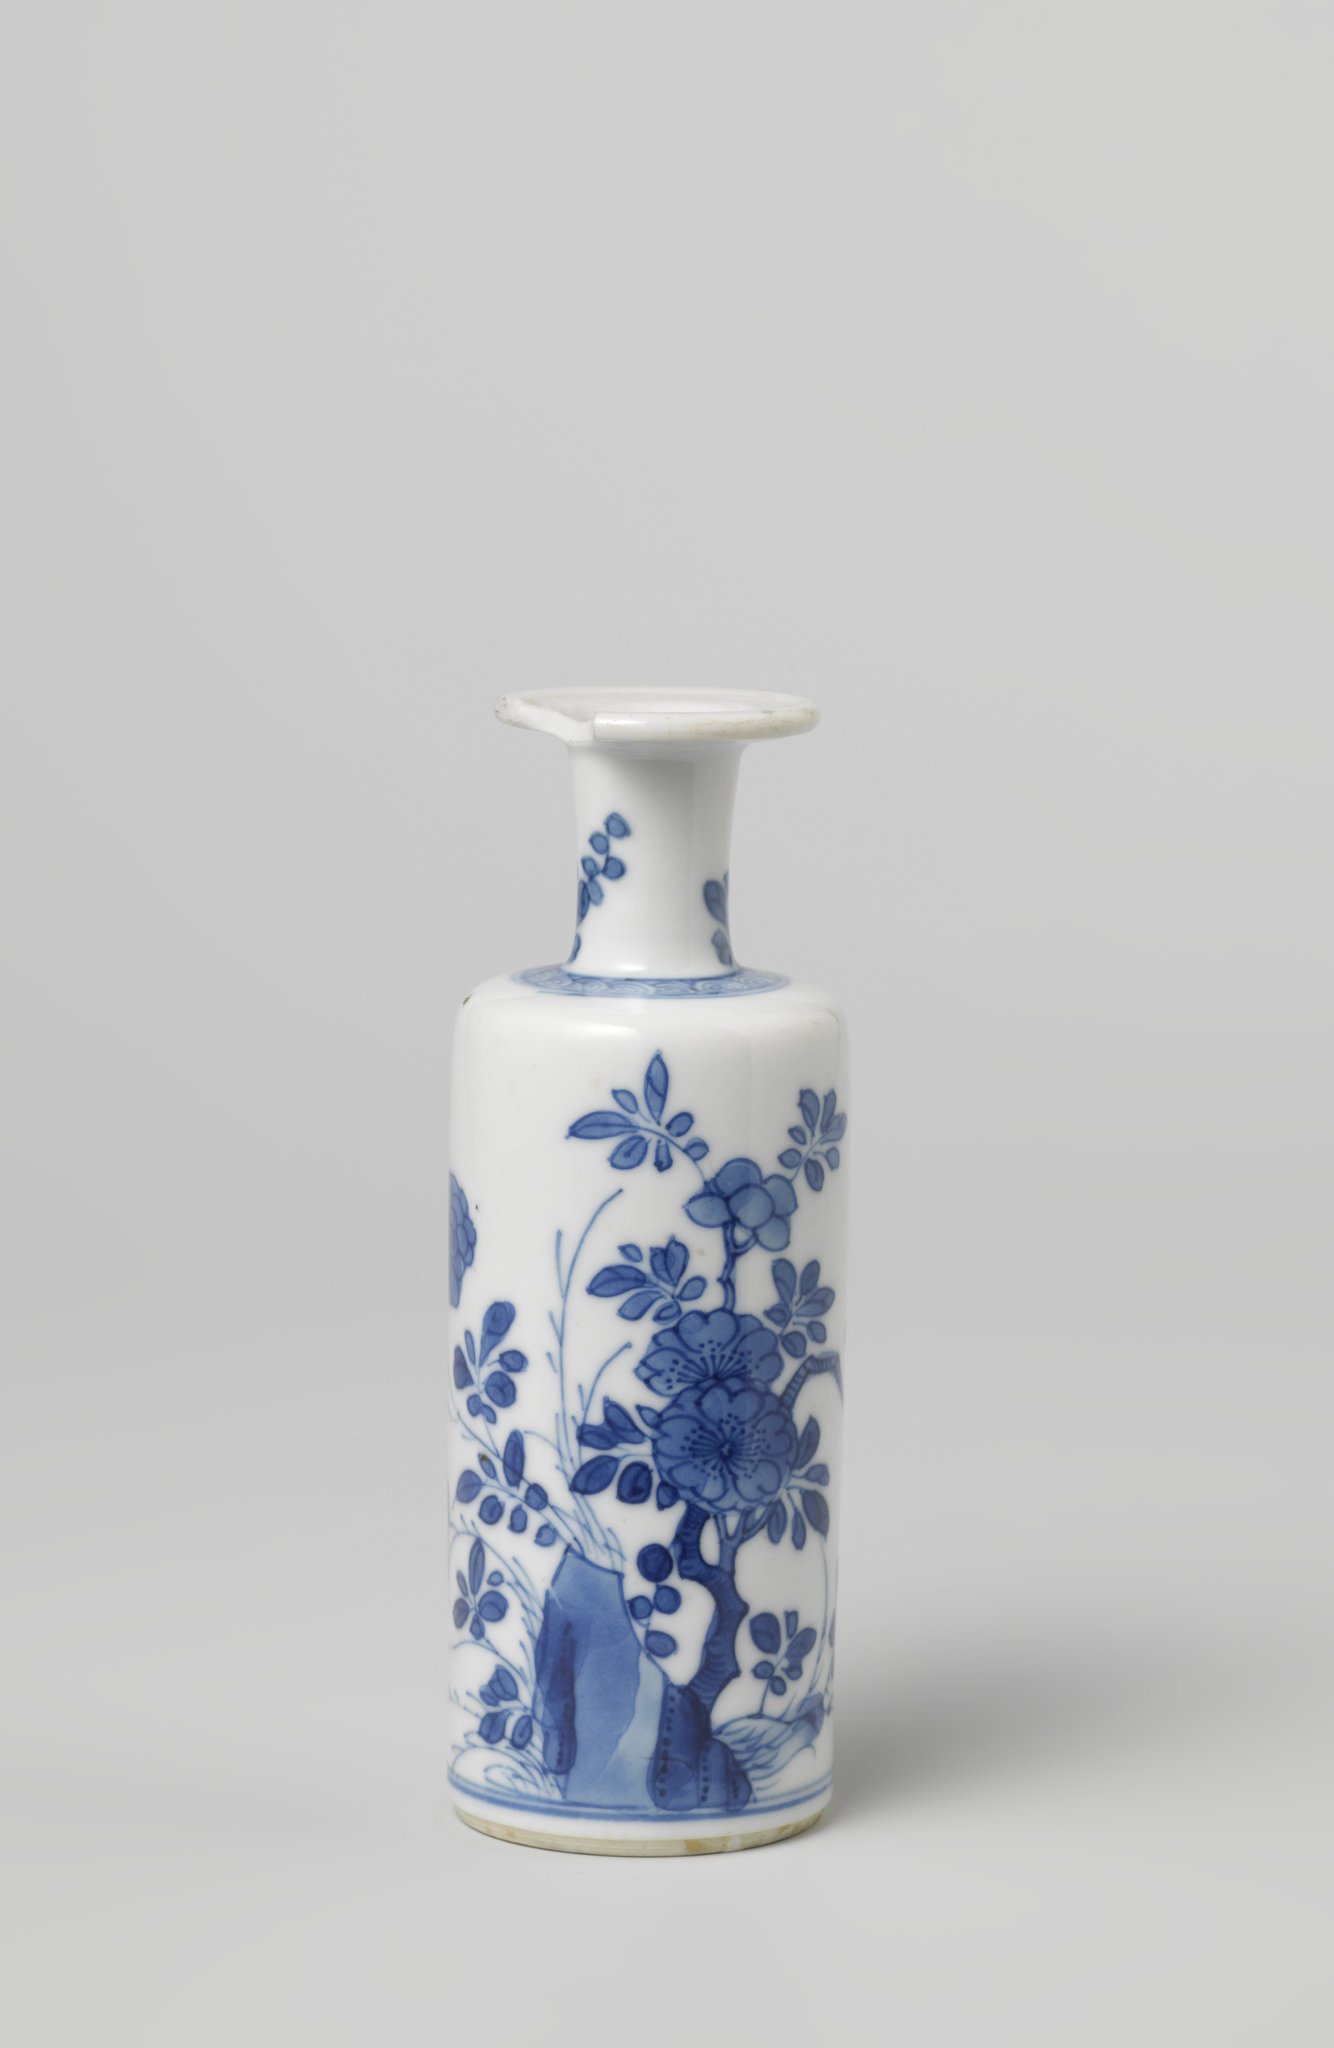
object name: vase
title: Small cilindrical vase with a flowering plant near a rock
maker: Anonymous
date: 1680-1720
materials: cobalt, glaze, paint, porcelain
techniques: firing, turning, vitrification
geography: china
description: Kleine, cilindrische vaas van porselein met een korte nek en platte rand, beschilderd in onderglazuur blauw. Op de wand een bloeiende planten (camelia) bij een rots en twee vliegende insecten. Op de schouder een band met een spiraalpatroon. De nek met twee bloemtakken. Een scherf uit de hals. Blauw-wit.